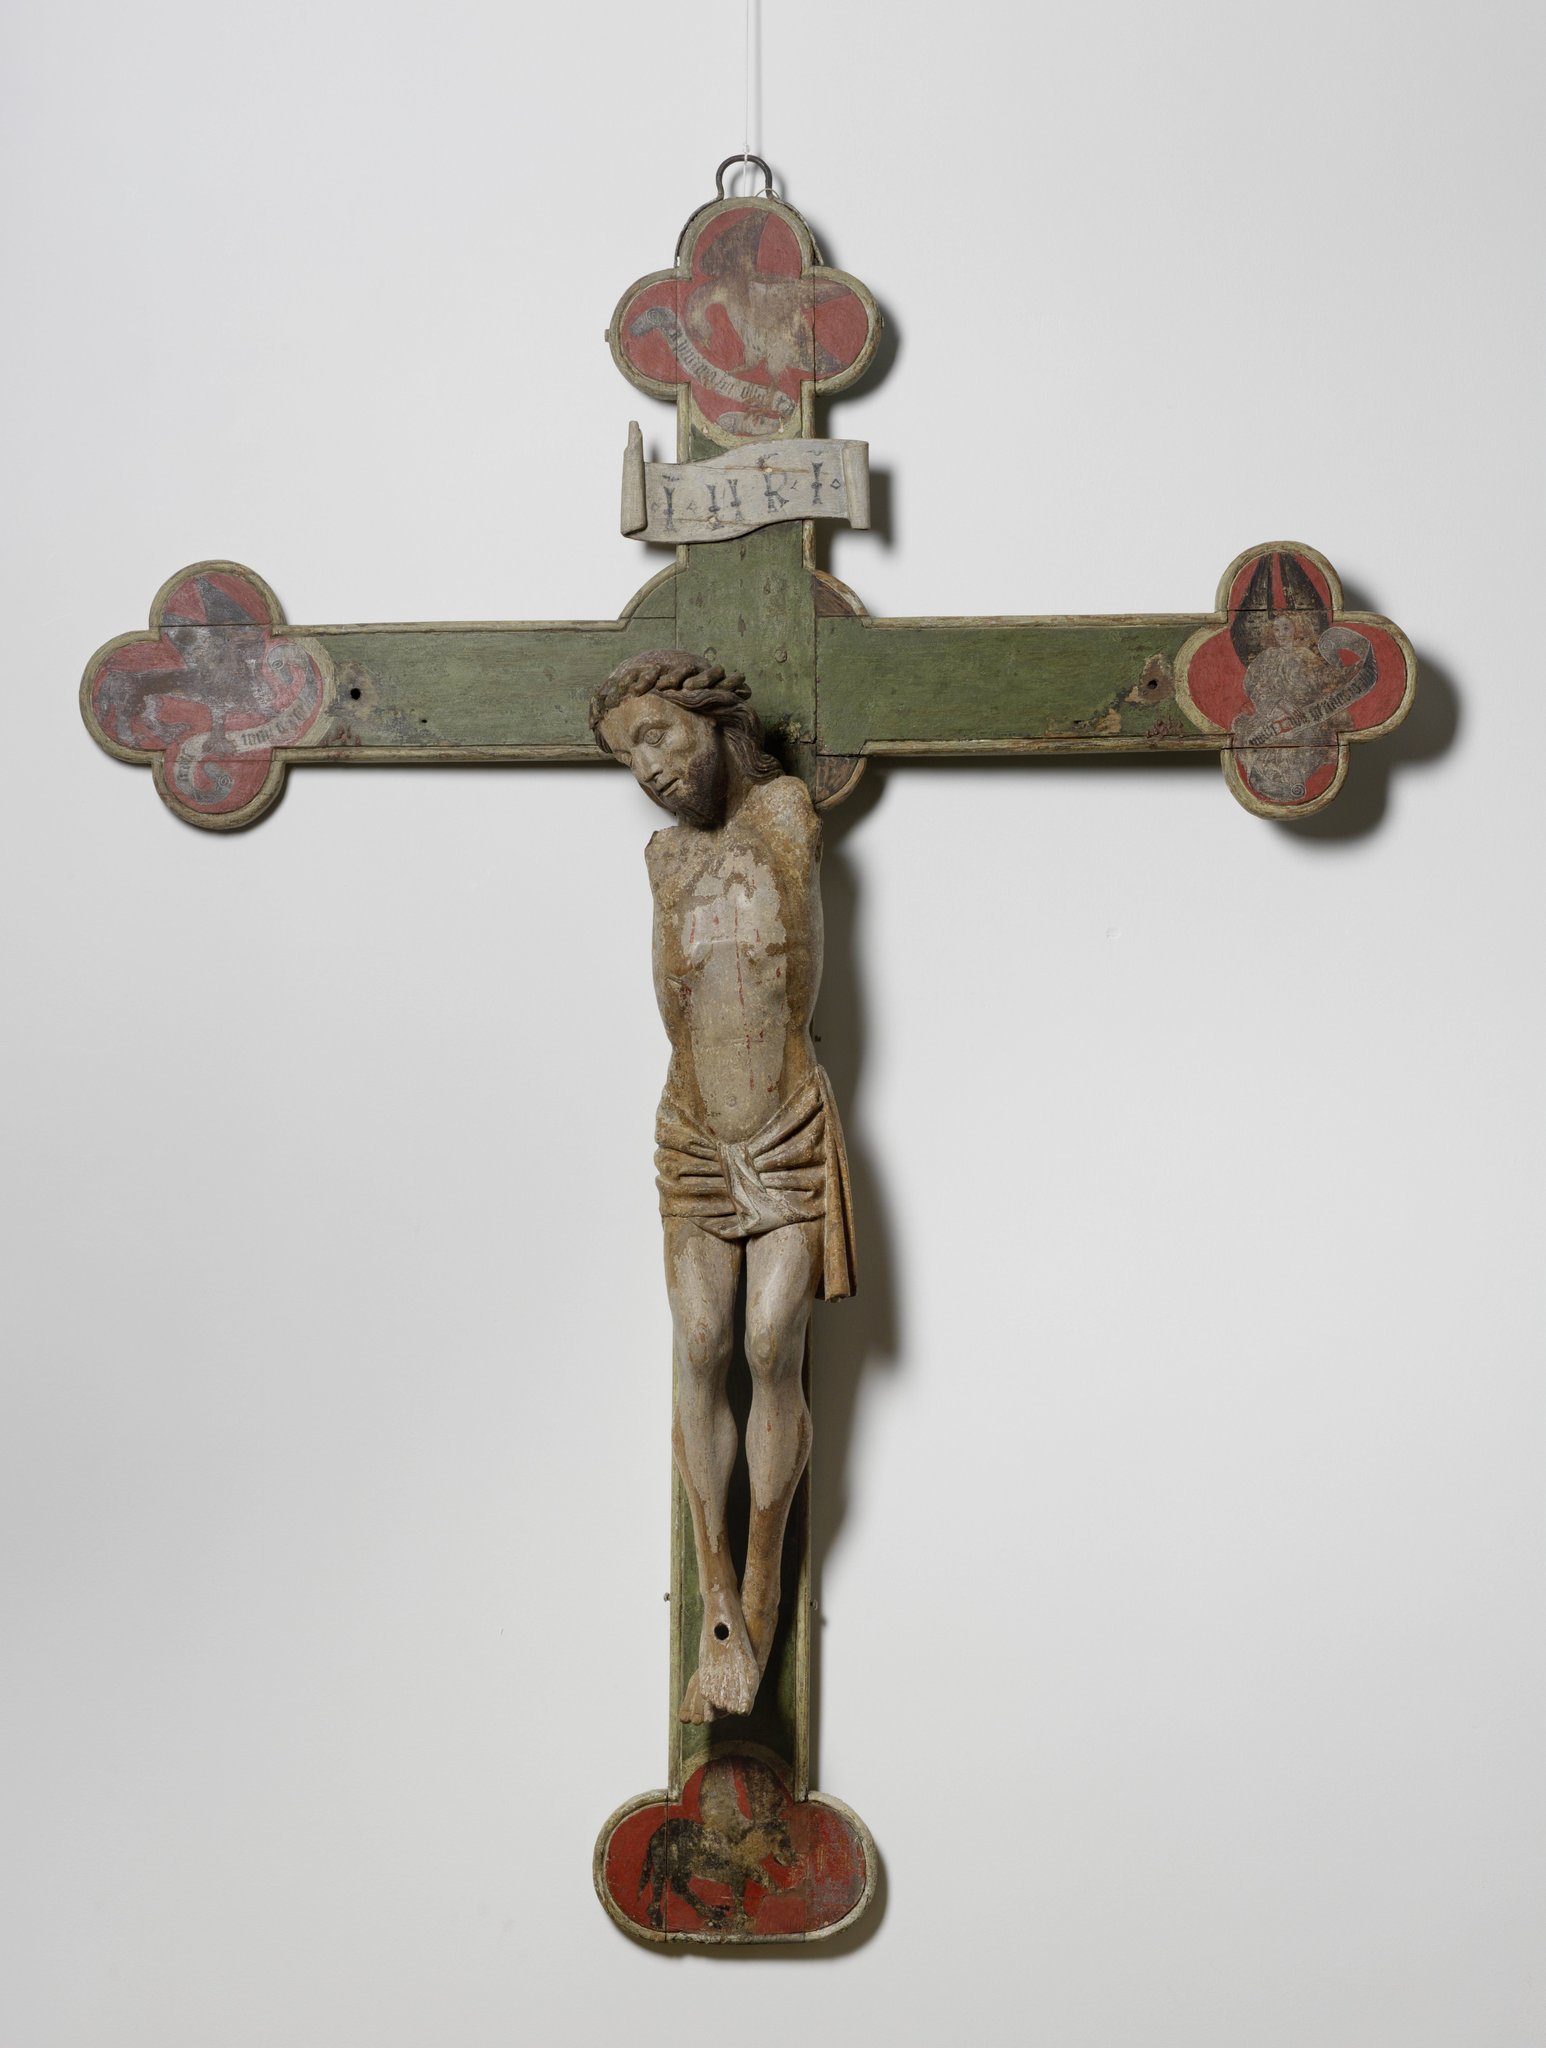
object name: crucifix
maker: Anonymous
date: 1470-1490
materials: iron, wood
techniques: gilding, polychromy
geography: north brabant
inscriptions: inscription, on the banderole on the left quatrefoil: illegible, inscription, on the banderole on the right quatrefoil: illegible, inscription, on the Titulus Crucis, painted: ‘INRI’, inscription, on the banderole on the quatrefoil at the top: illegible, inscription, on the banderole on the trefoil at the bottom: illegible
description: Master of Koudewater (?) (active c. 1460 - c. 1480). Crucifix. Walnut and oak, with some original polychromy. 's-Hertogenbosch, c. 1470.